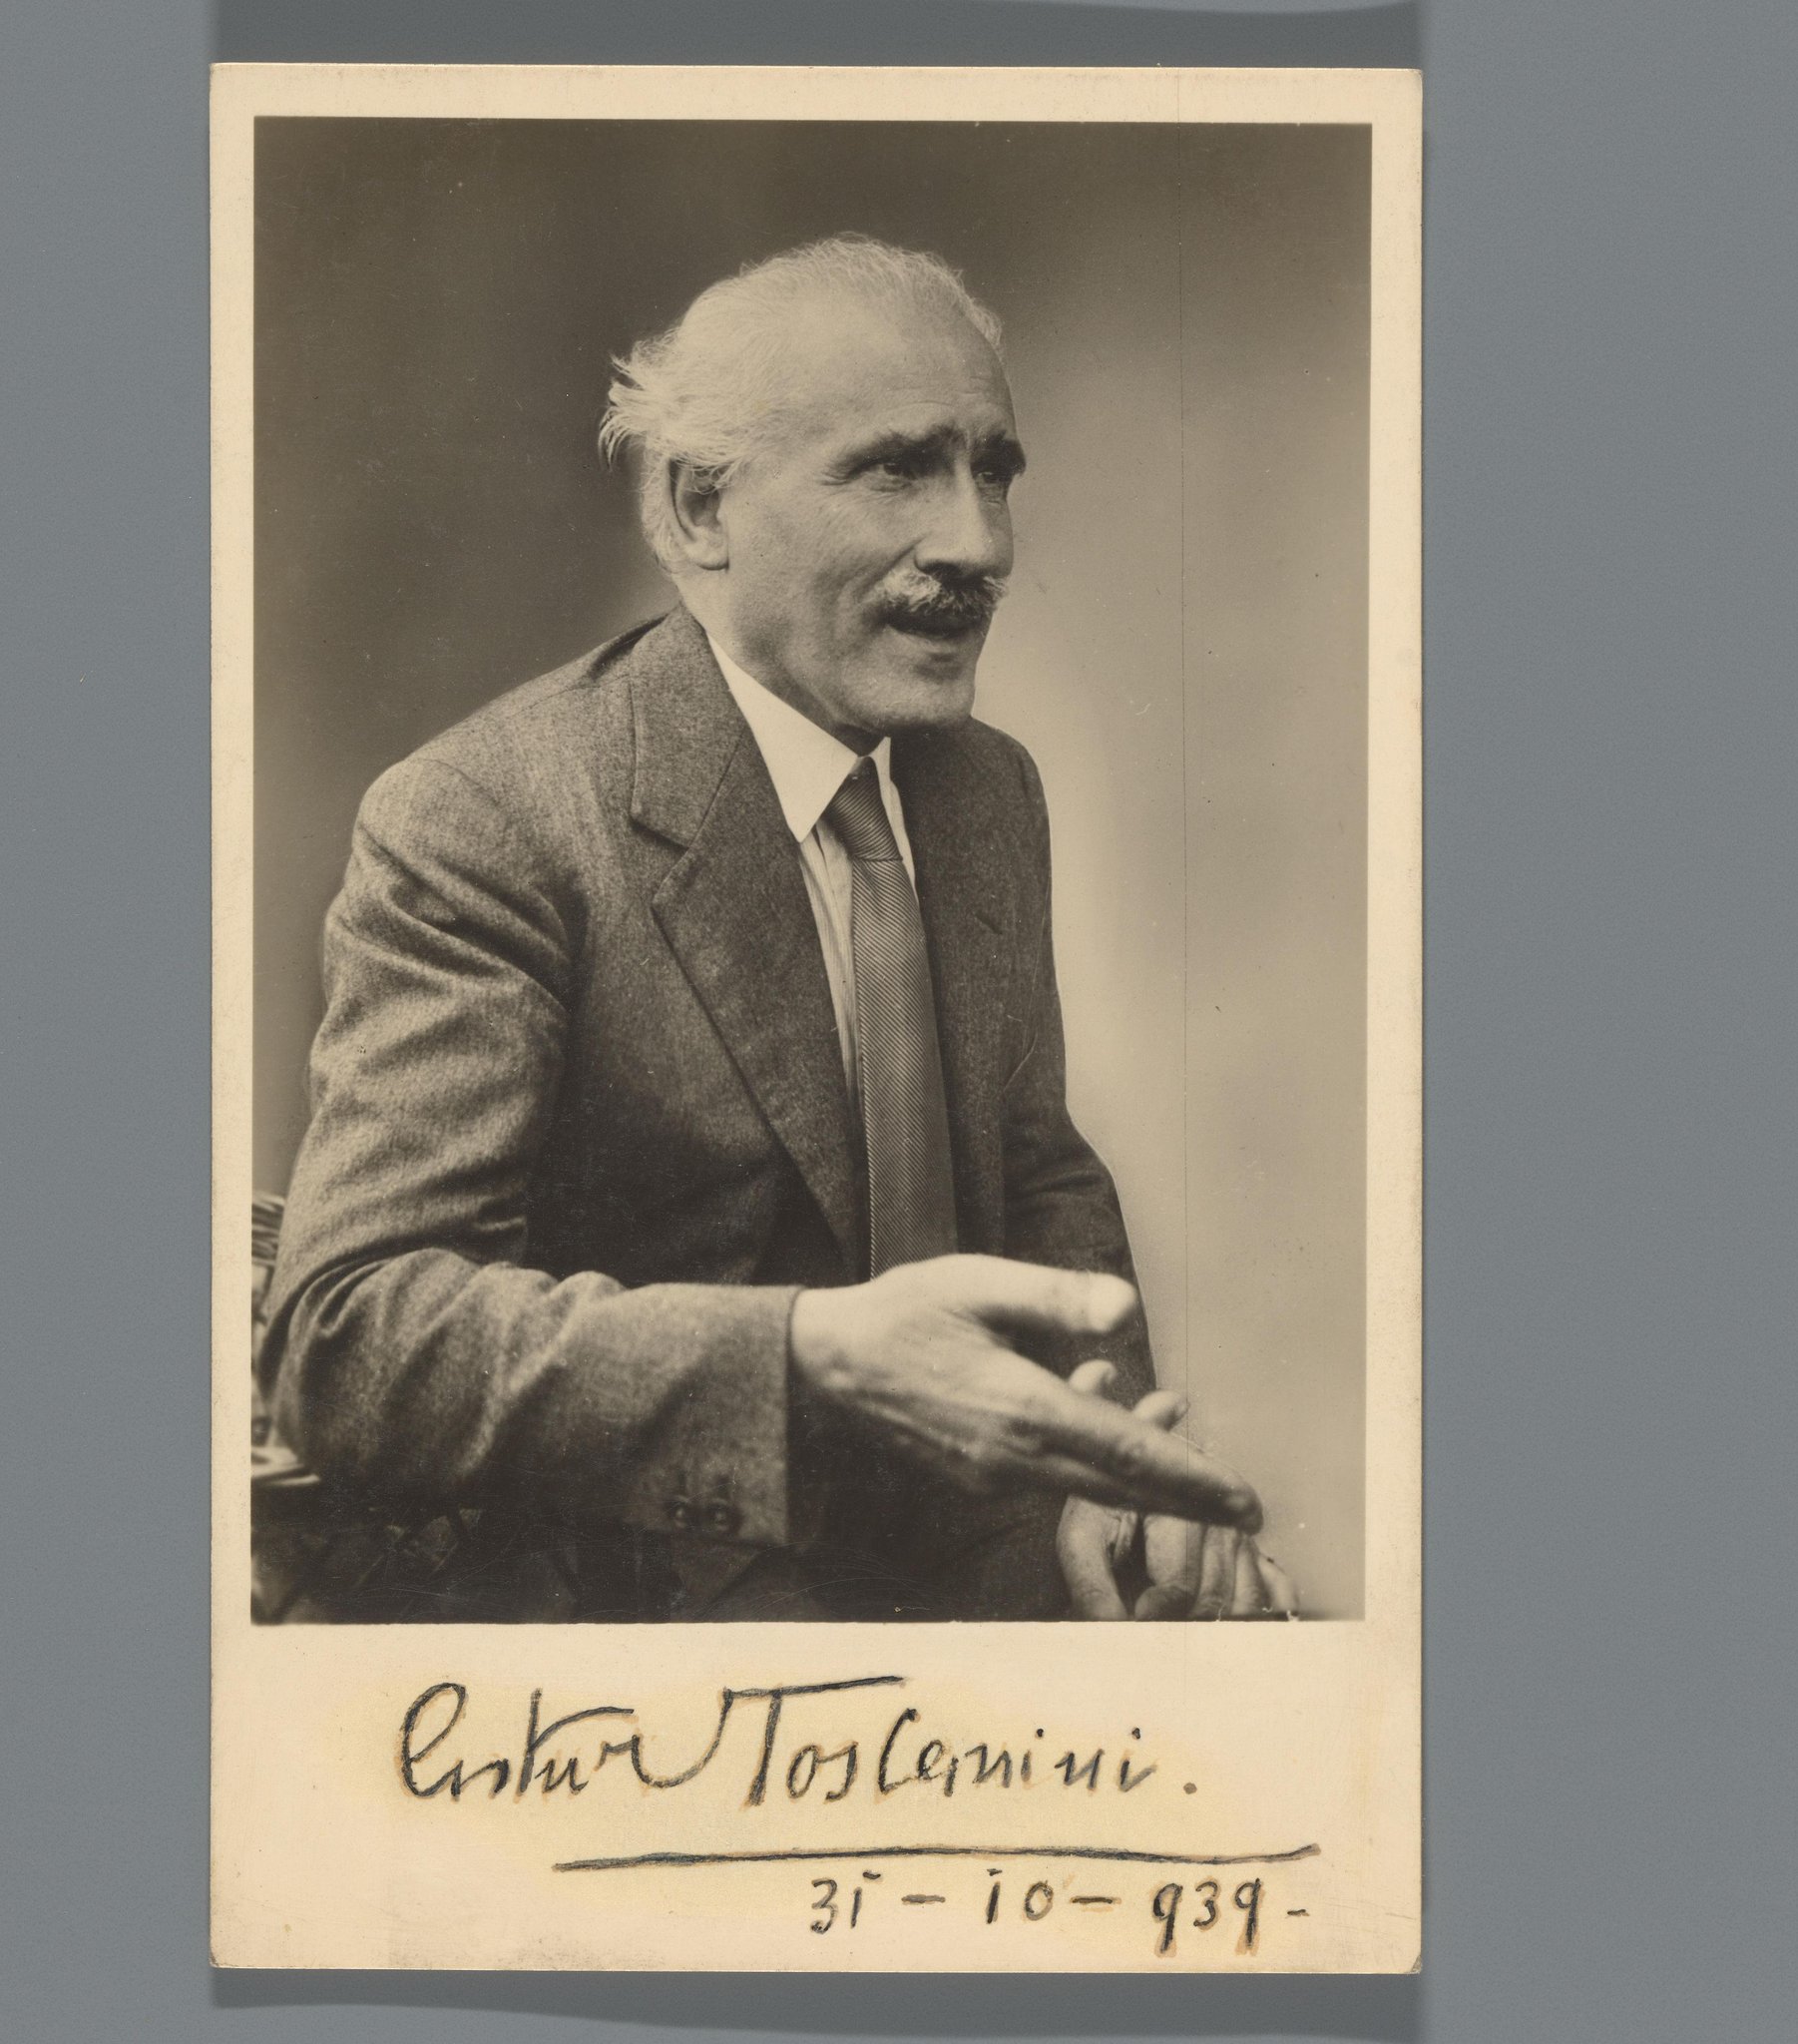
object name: photograph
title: Portret van Arturo Toscanini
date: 1936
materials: paper, ink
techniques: gelatin silver print, pen, writing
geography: salzburg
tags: conductor ~ music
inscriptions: inscription: ‘Salzburg, Bismarkstrasse 4./ Copyright 1936 by Foto Rothmaier, Jede Nachbildung verboten’, signature: ‘Artur Toscanini/ 31-10-939-’